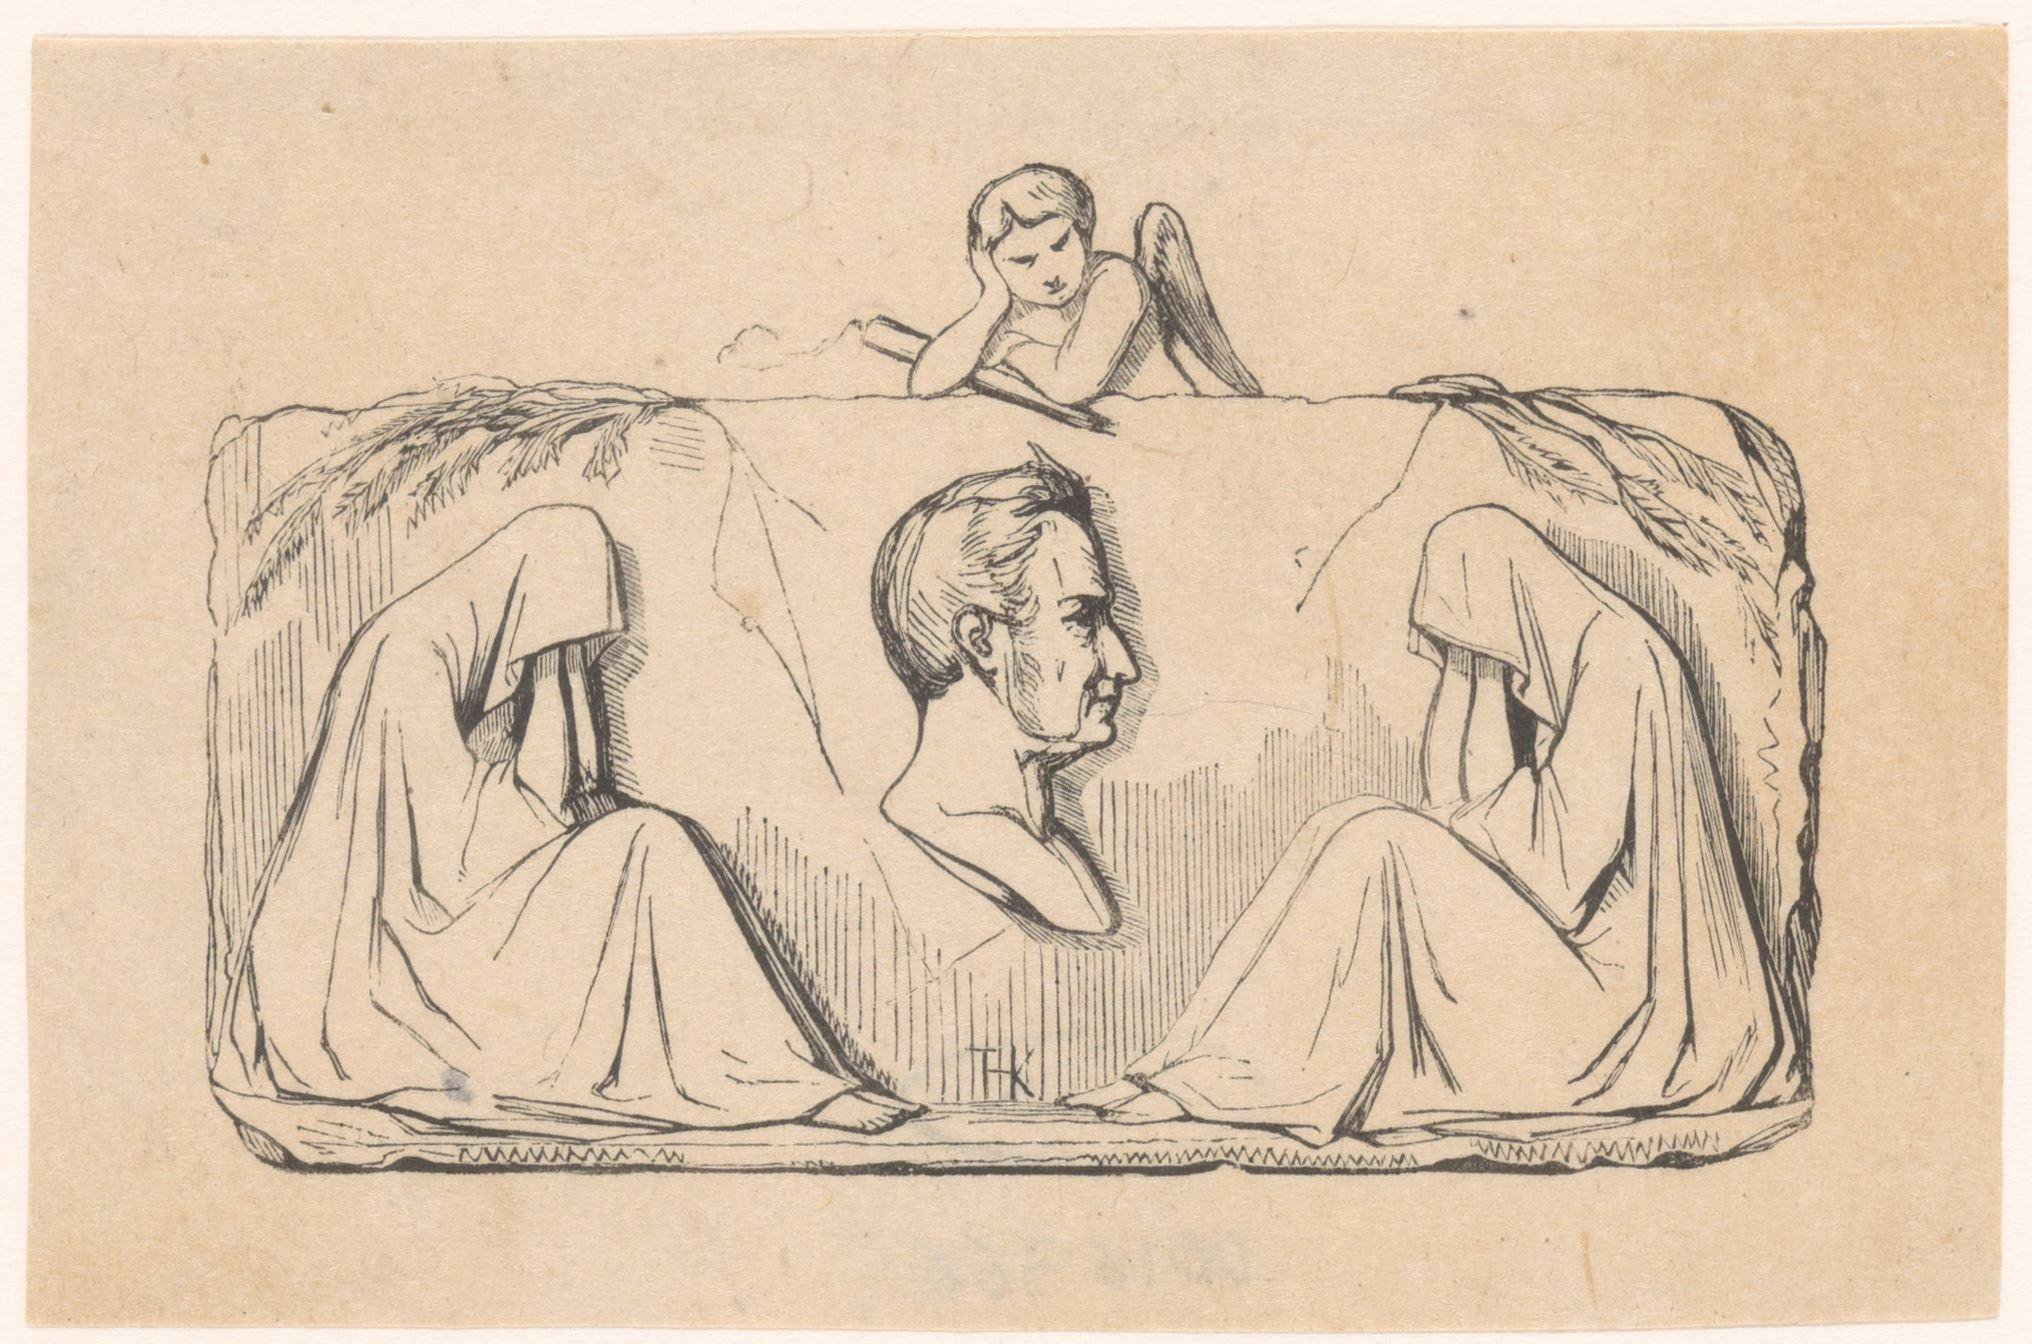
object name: print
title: Twee treurende, gesluierde vrouwen naast een buste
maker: theodorus henricus kerstel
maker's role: print maker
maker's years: 1859-1936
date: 1869-1936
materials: paper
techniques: line block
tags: cherubs, i.e. children's heads with wings, piece of sculpture, reproduction of a piece of sculpture, veil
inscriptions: collector's mark: Lugt 2228